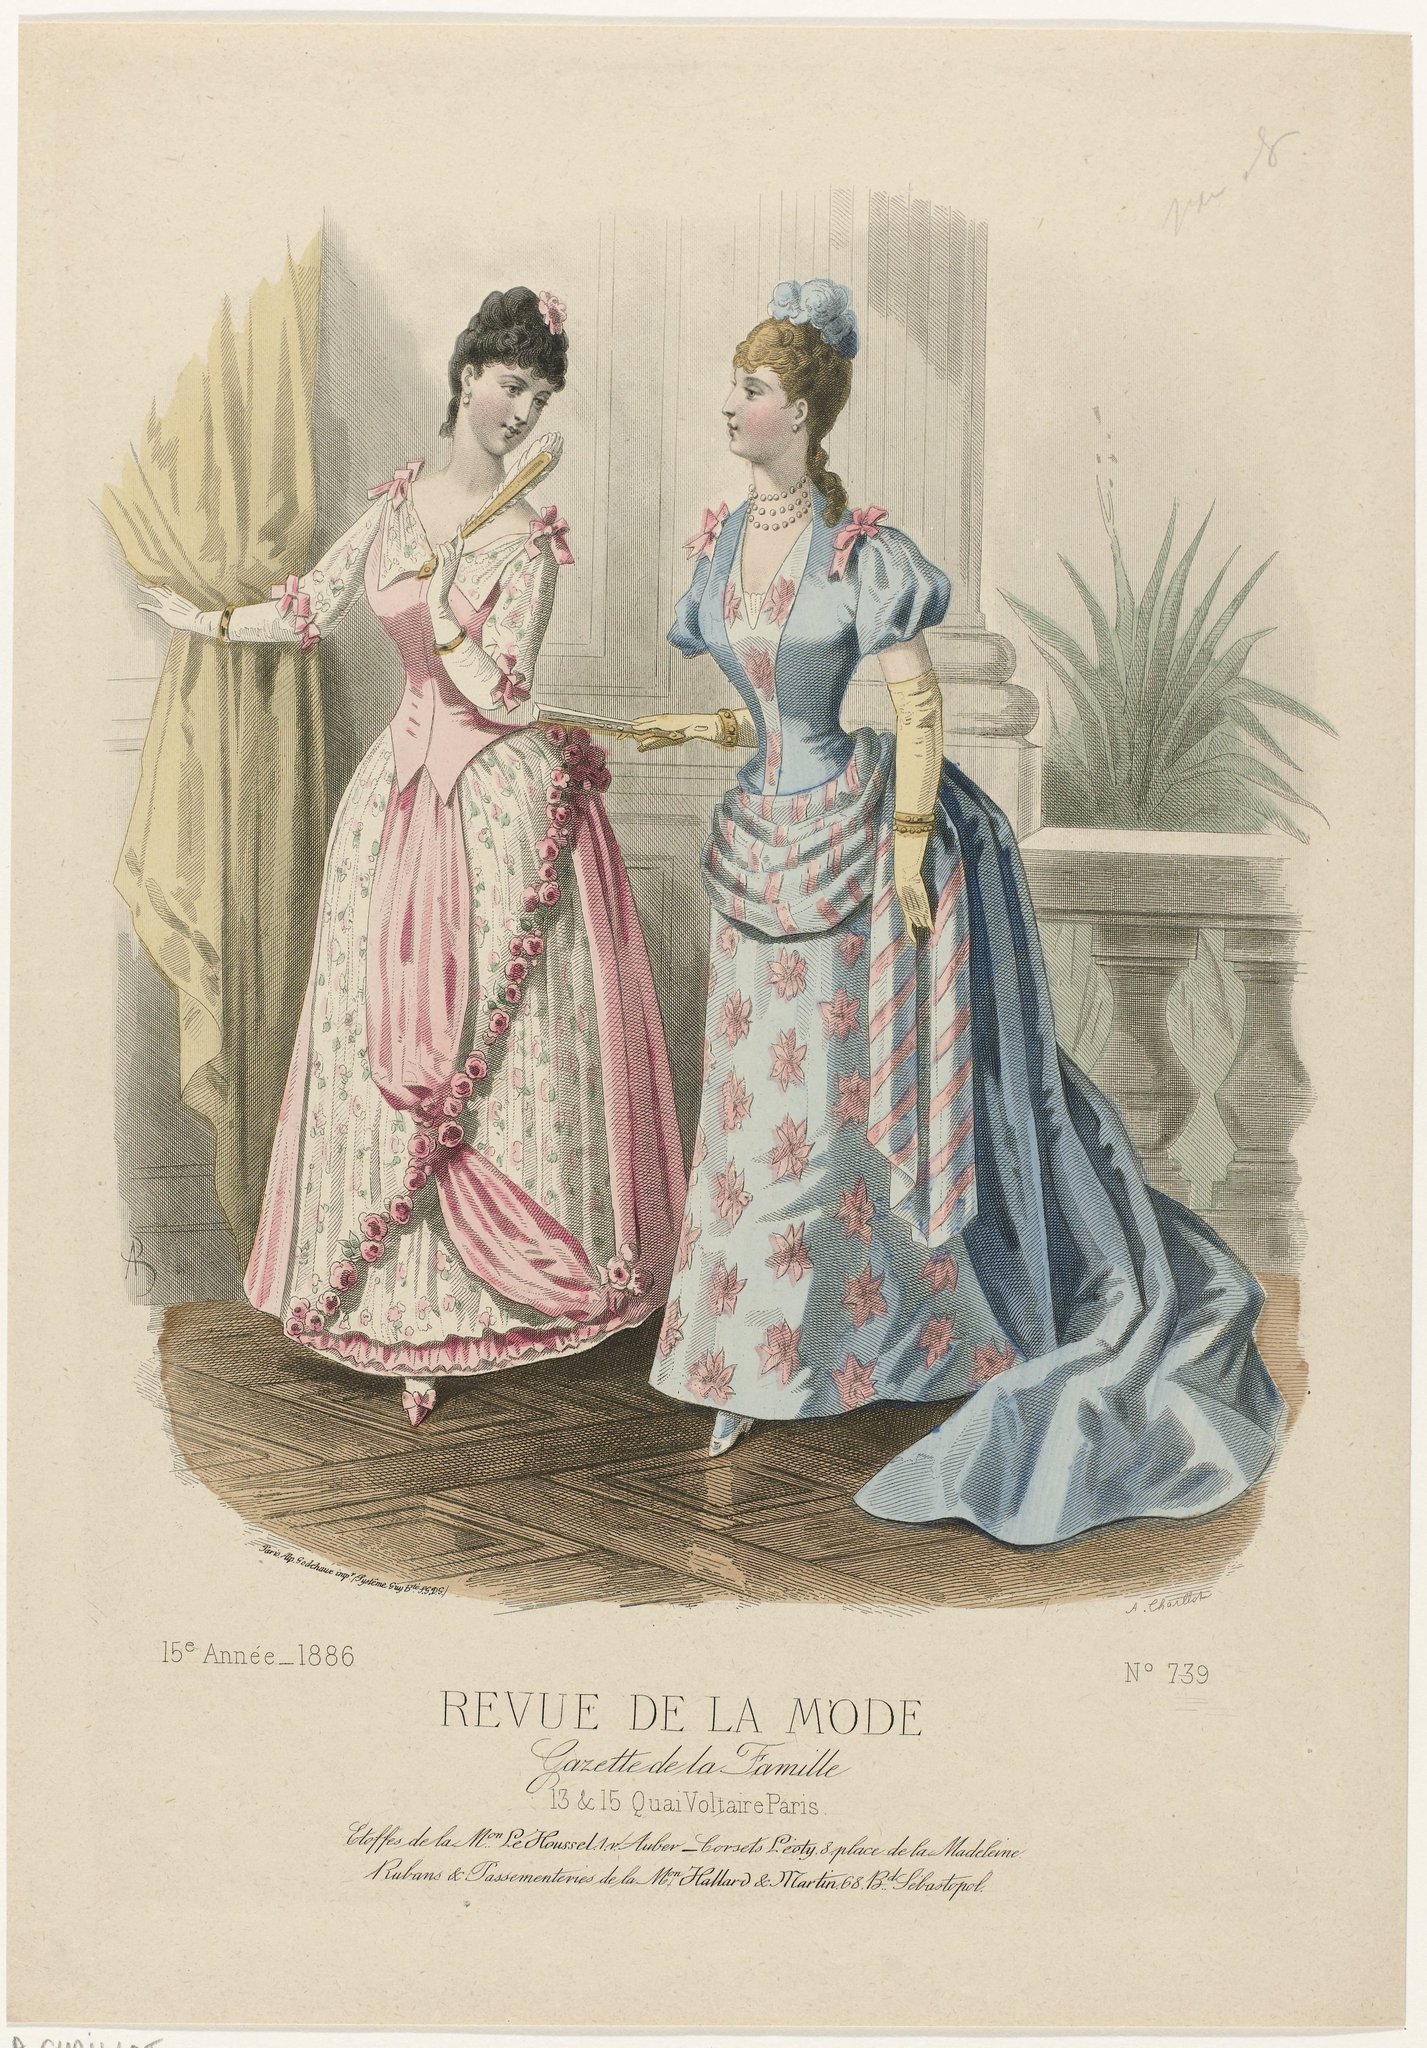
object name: fashion print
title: Revue de la Mode, Gazette de la Famille, dimanche 28 février 1886, 15e Année, No. 739 : Etoffes de la M.on Le Houssel (...)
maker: a. chaillot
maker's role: print maker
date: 1886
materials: paper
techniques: engraving, hand coloring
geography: paris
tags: bow (ornamental part of clothing) (+ women's clothes), clothing for the upper part of the body (shawl) (+ women's clothes), fashion plates, dress, gown (+ women's clothes), fan (+ women's clothes), flowers: rose, bracelet, wristlet (+ women's clothes), necklace (+ women's clothes)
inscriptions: address: ‘13 & 15, Quai Voltaire Paris’, title: ‘REVUE DE LA MODE / Gazette de la Famille’, caption: ‘Etoffes de la M.on Le Houssel 1 r. Auber._ Corsets Léoly, 8, place de la Madeleine Rubans & Passementeries de la M.on Hallard & Martin, 68, B.d Sébastopol’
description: Twee vrouwen in een interieur. Links: japon voor een diner, bal of 'petite soirée', geschikt voor een jonge vrouw. De japon is van crèmekleurige zijde bedrukt met rozen motief en roze Surah. De rok is versierd met een drapering van roze Surah en guirlande van rozen. Rechts: japon voor een diner of 'petit soirée' van lichtblauwe crêpe de Chine en gebrocheerd met roze (bloemmotief). Korte pofmouwen met op de schouders roze strikken.Om het middel een gestreepte sjaal van gestreept gaas in lichtblauw en roze. Onder de voorstelling enkele regels reclametekst voor verschillende producten. Prent uit het modetijdschrift Revue de la Mode (1872-1913). Uitgebreide beschrijving van de kleding op pagina 67 "PLANCHE COLORIÉE".